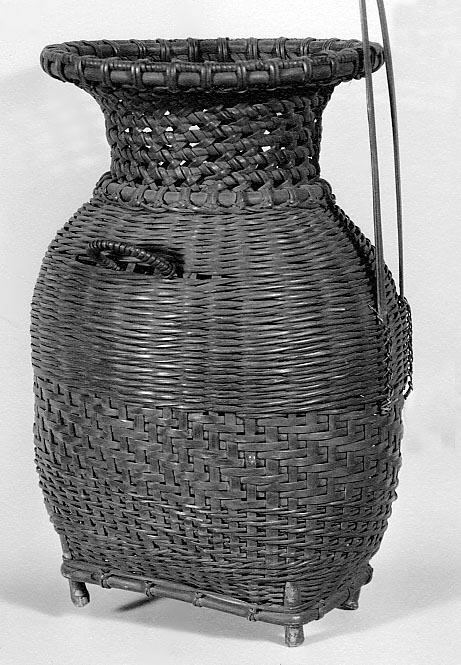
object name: basket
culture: japanese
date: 1801-1900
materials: bamboo